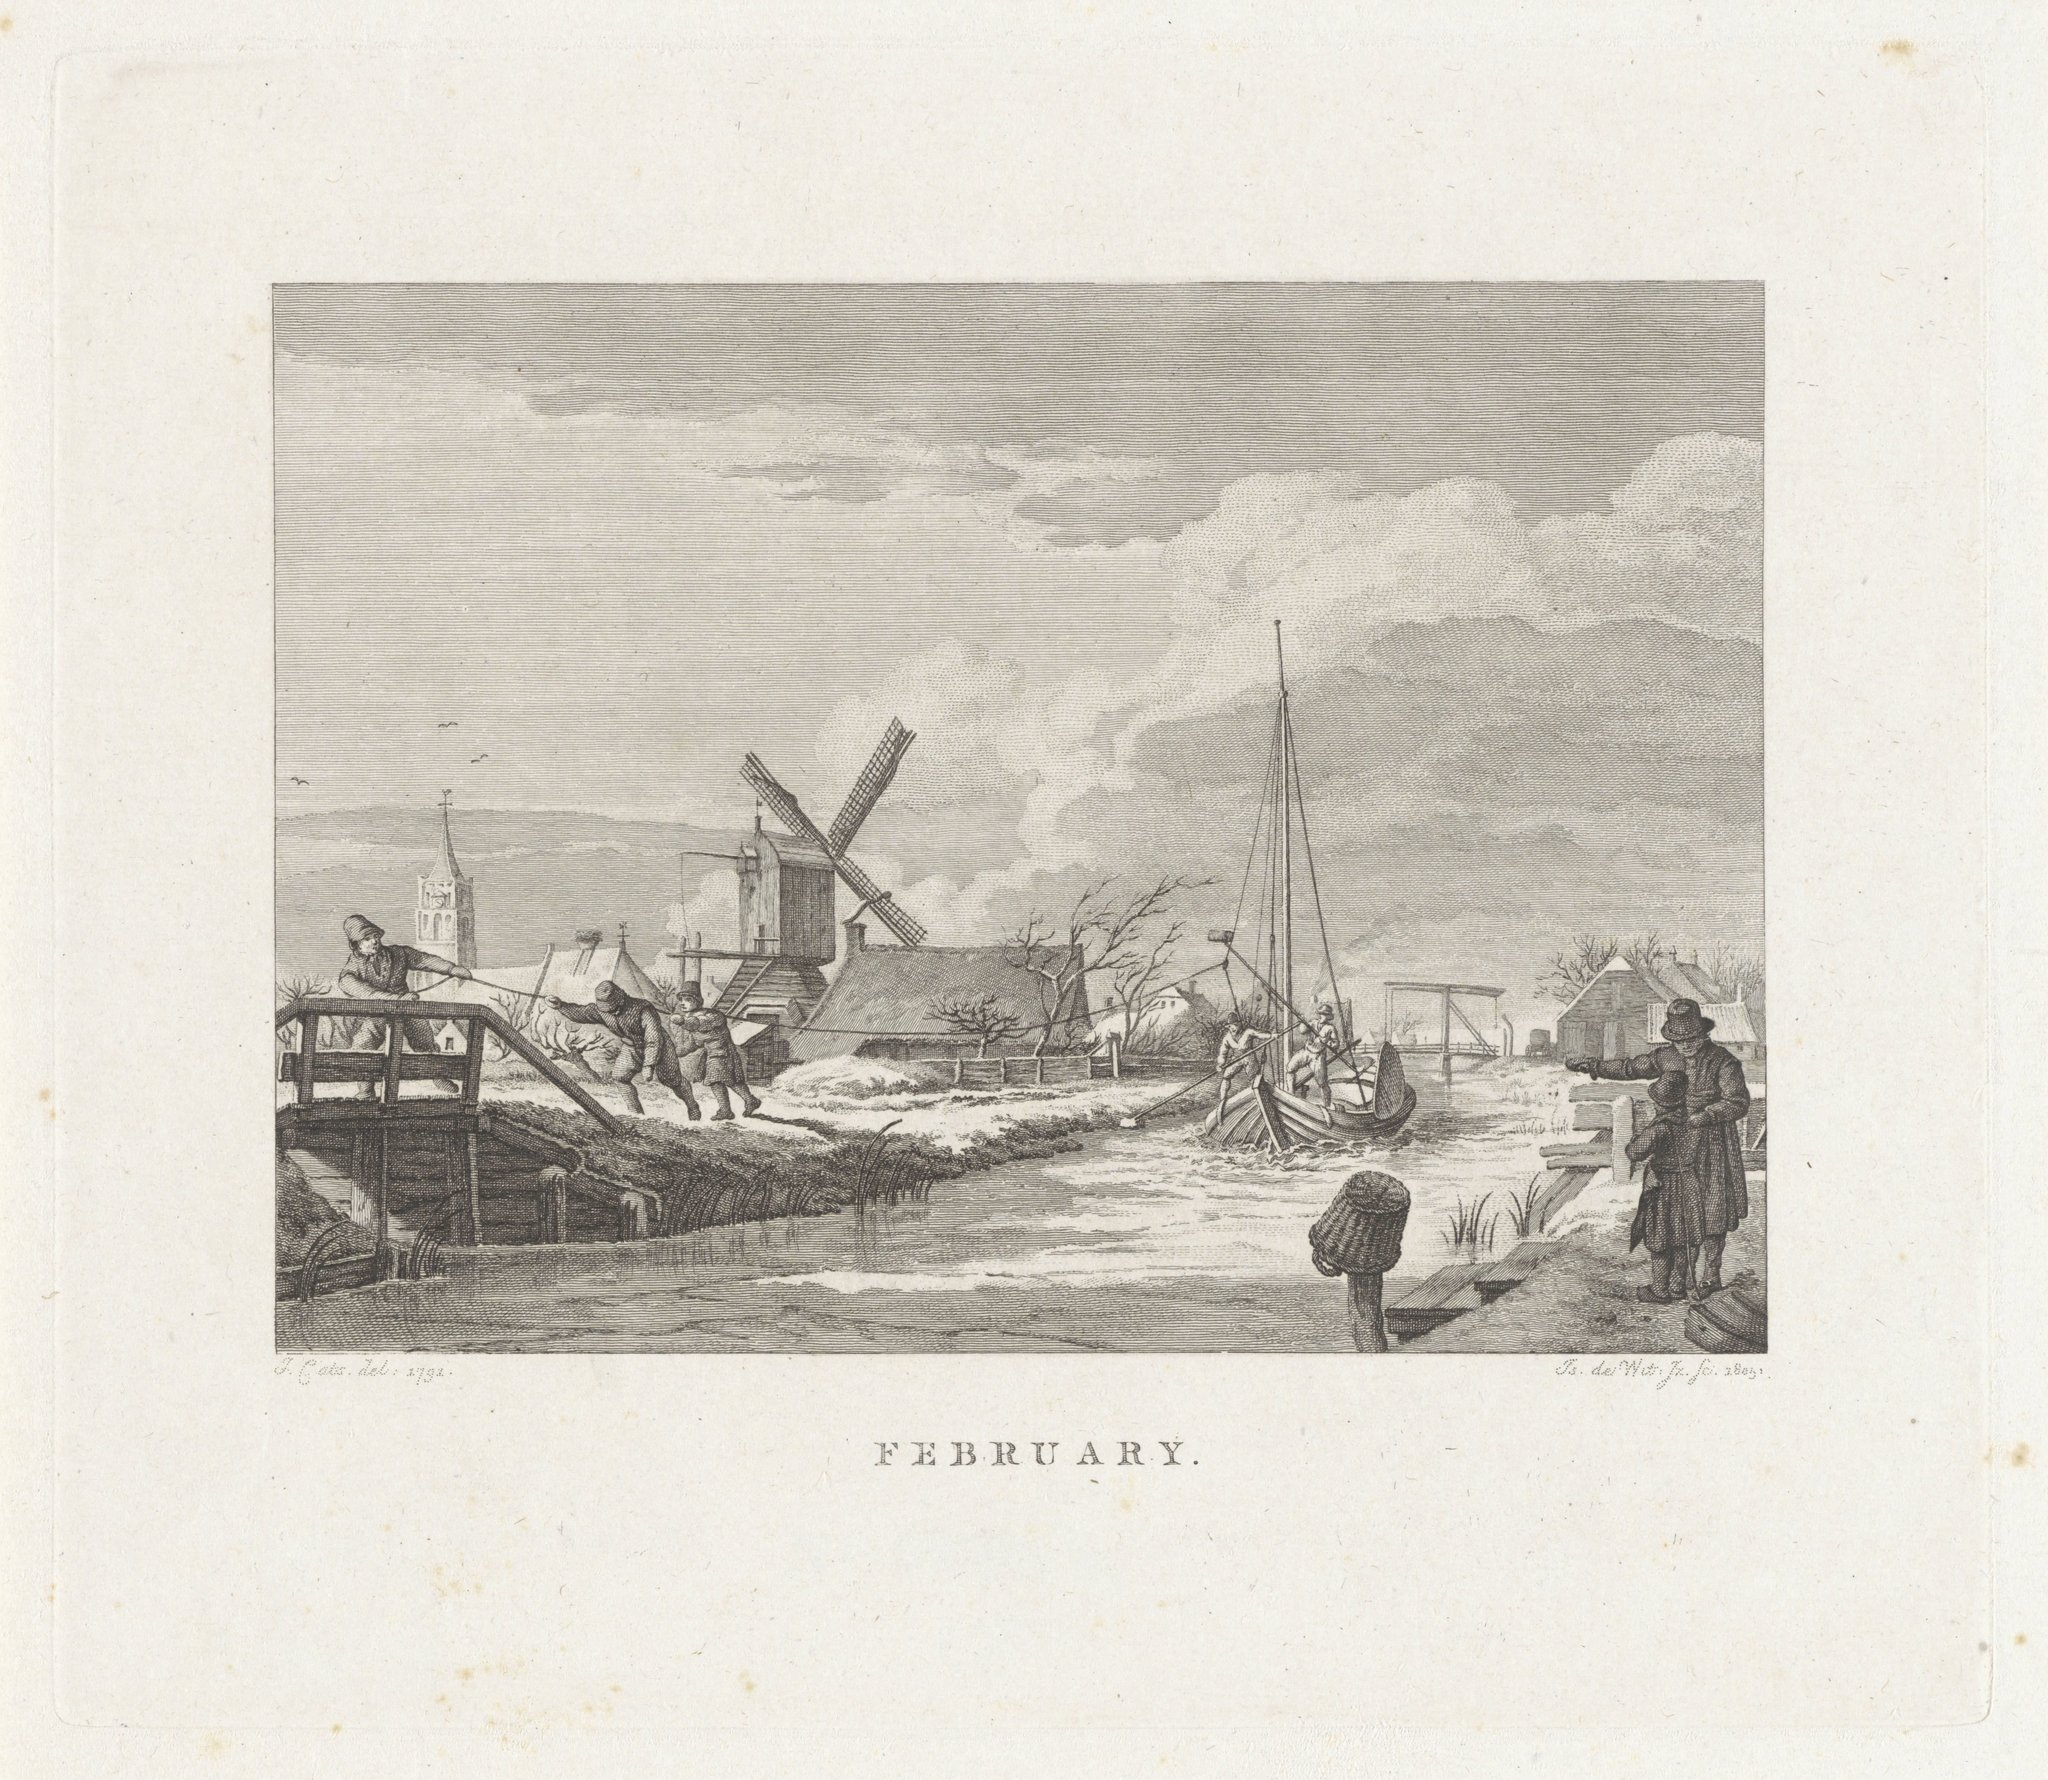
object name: print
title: February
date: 1805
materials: paper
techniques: etching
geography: haarlem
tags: february and its 'labours' (+ with scenes showing human occupations ~ seasons and months), tow-boat, towing-barge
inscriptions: collector's mark: Lugt 2228